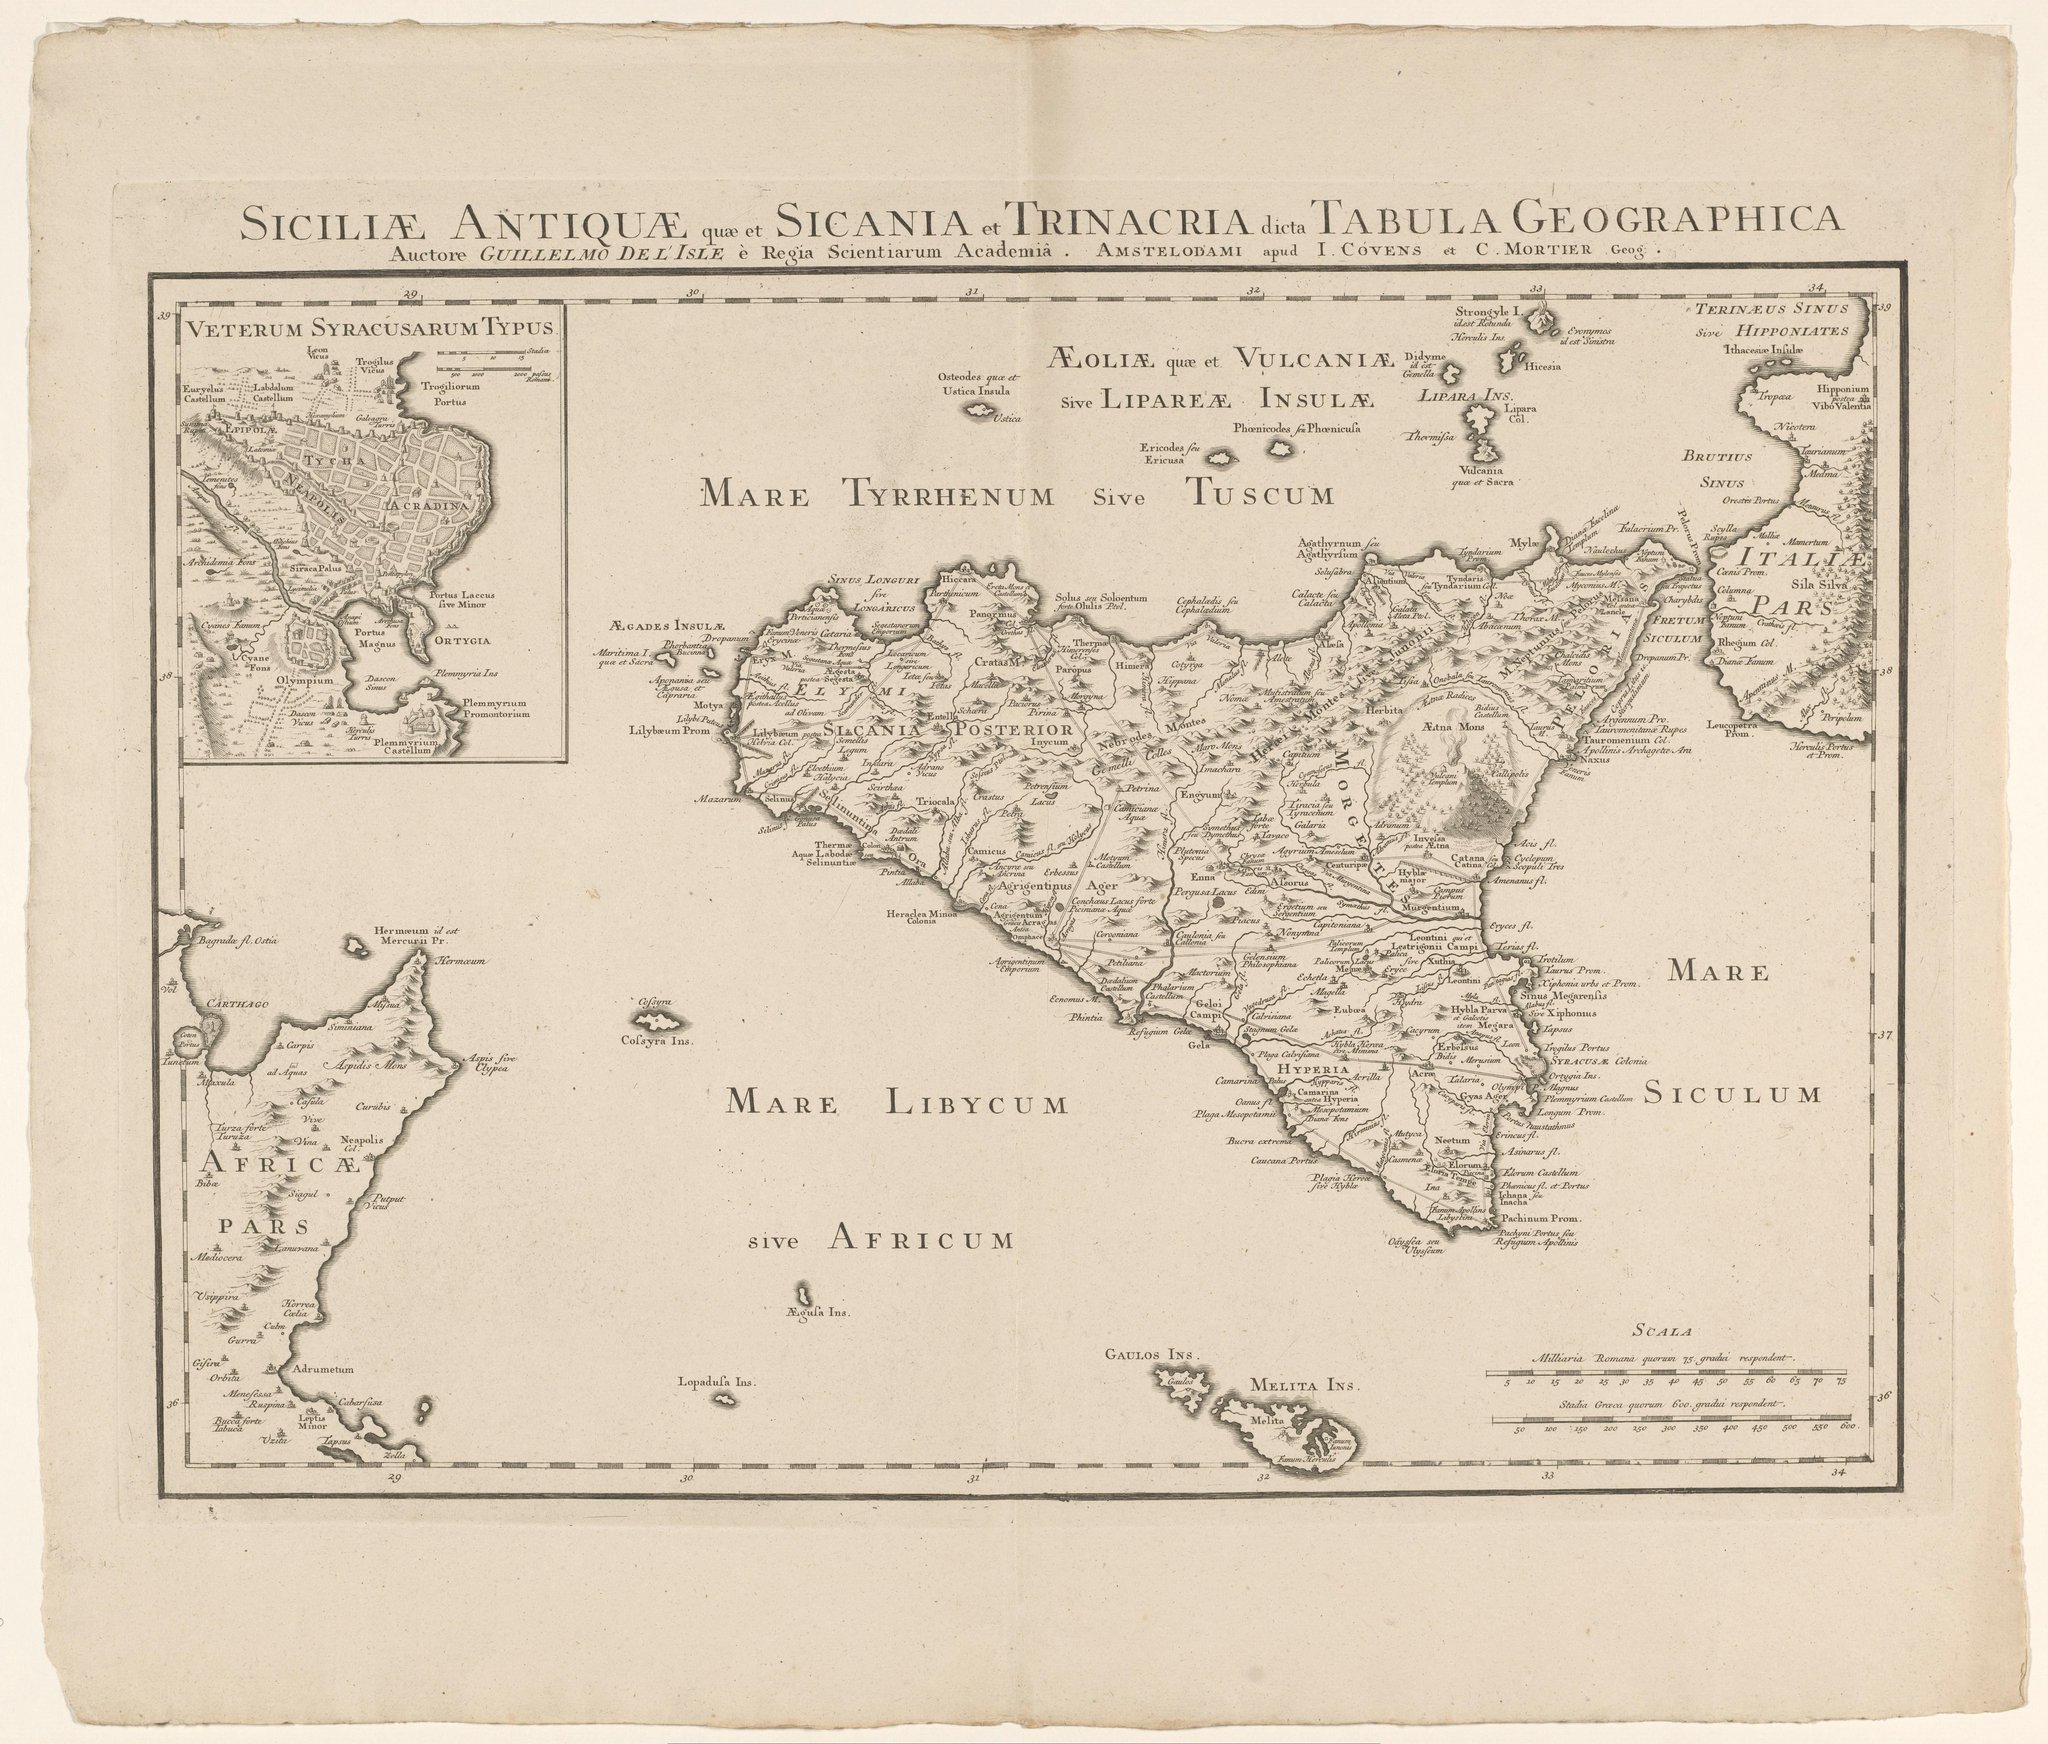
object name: map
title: Kaart van Sicilië in de Romeinse tijd met een plattegrond van Syracuse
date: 1721-1774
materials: paper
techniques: engraving, etching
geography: paris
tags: maps of separate countries or regions, maps of cities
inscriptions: collector's mark: Lugt 2228, collector's mark: Lugt 1641a